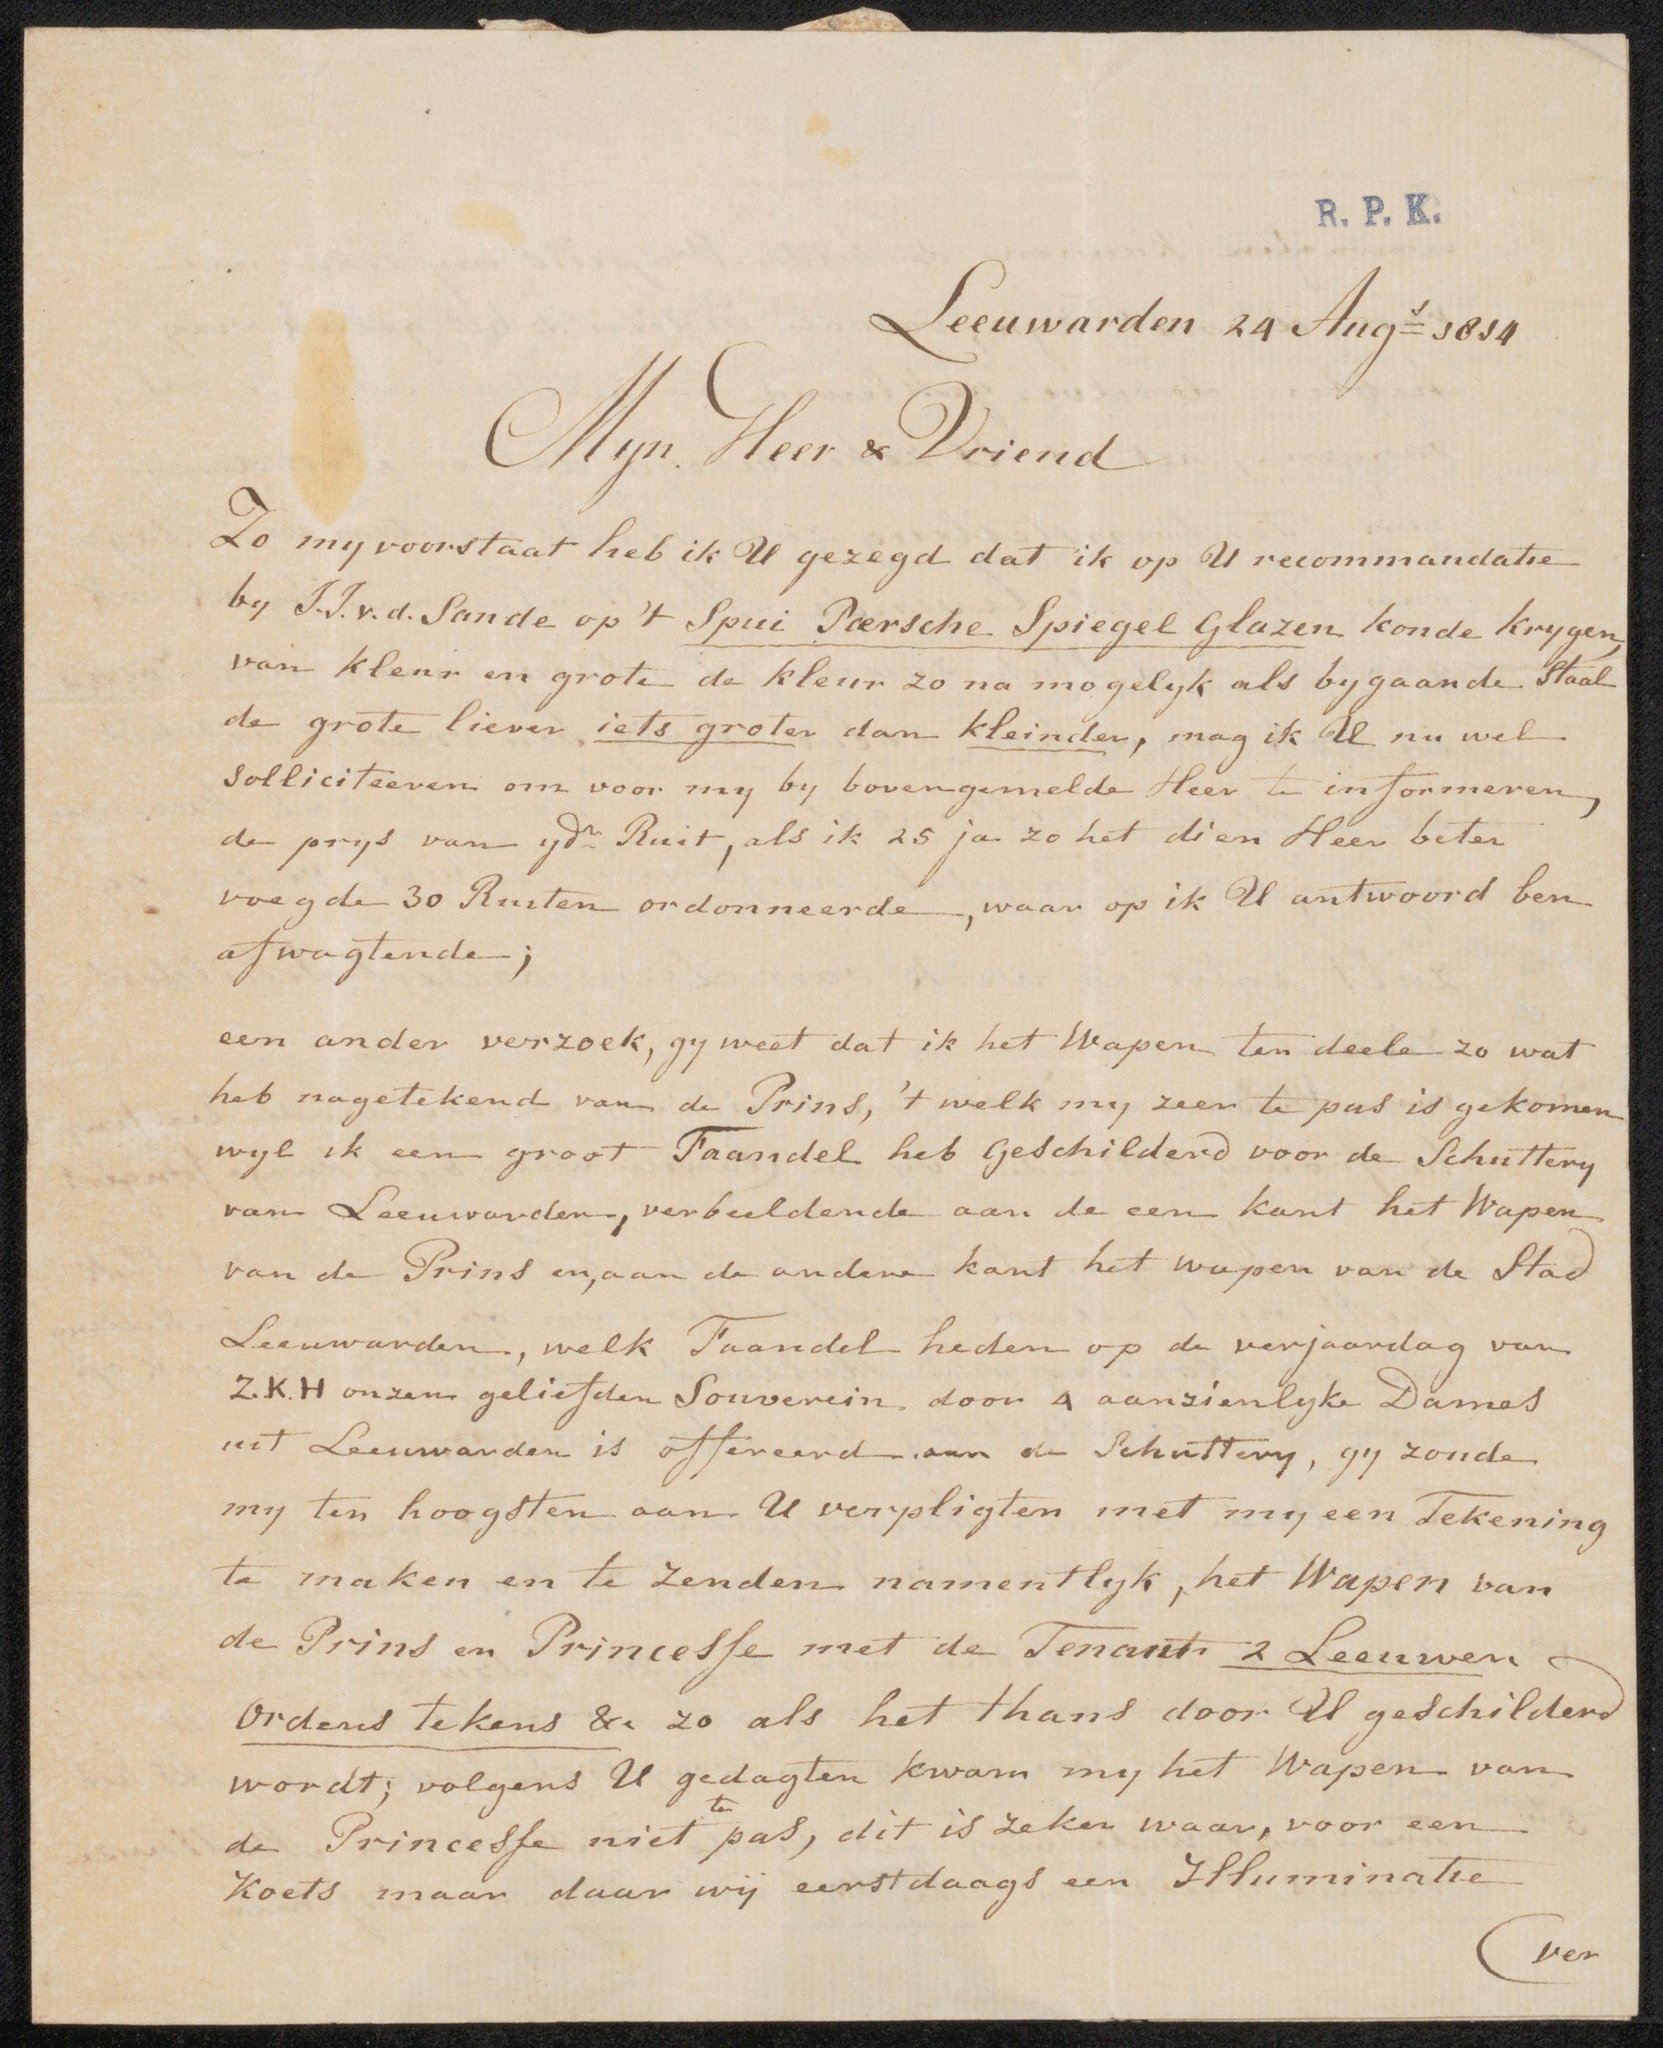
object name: letter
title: Brief aan Lambertus Hardenberg (1744)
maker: jan hendrik nicolaij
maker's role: draughtsman, painter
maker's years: 1766-1826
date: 1814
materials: ink, paper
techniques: pen, writing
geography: leeuwarden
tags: the hague, lambertus hardenberg (1744), painter, print maker, draughtsman, willem bartel van der kooi, arnhem, jan rijk matthijssen, wilhelmina geertruida van idsinga, delft, carel jacob van baar van slangenburg, drawing, painting (including book-illumination, miniature-painting), exhibition ~ art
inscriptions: watermark, collector's mark: Lugt 2233